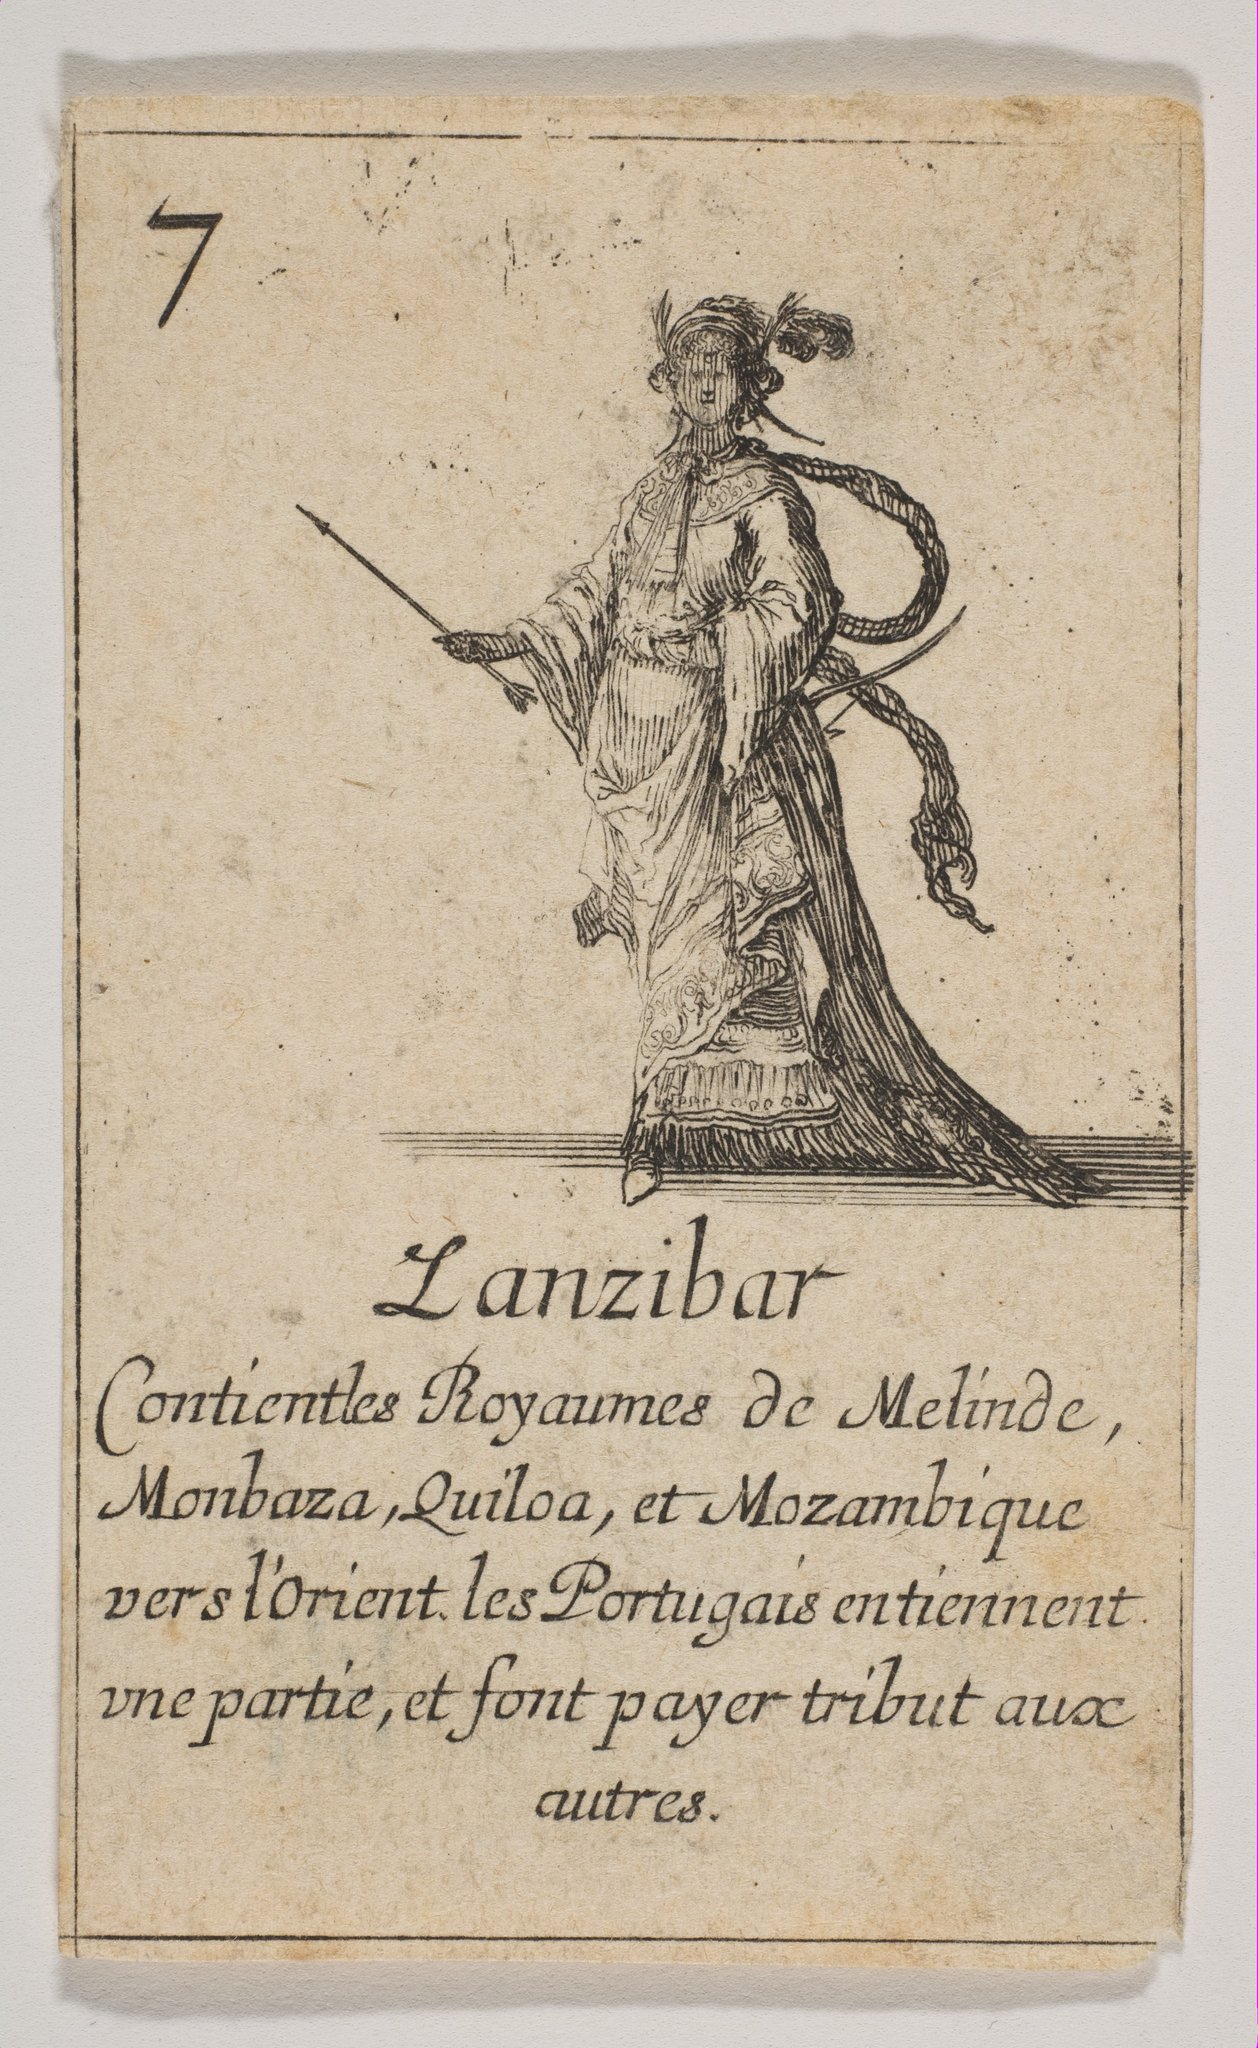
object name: print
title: Zanzibar, from "Jeu de la Géographie"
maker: stefano della bella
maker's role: artist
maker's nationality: italian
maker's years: 1610-1664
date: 1644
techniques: etching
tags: bow and arrow,women